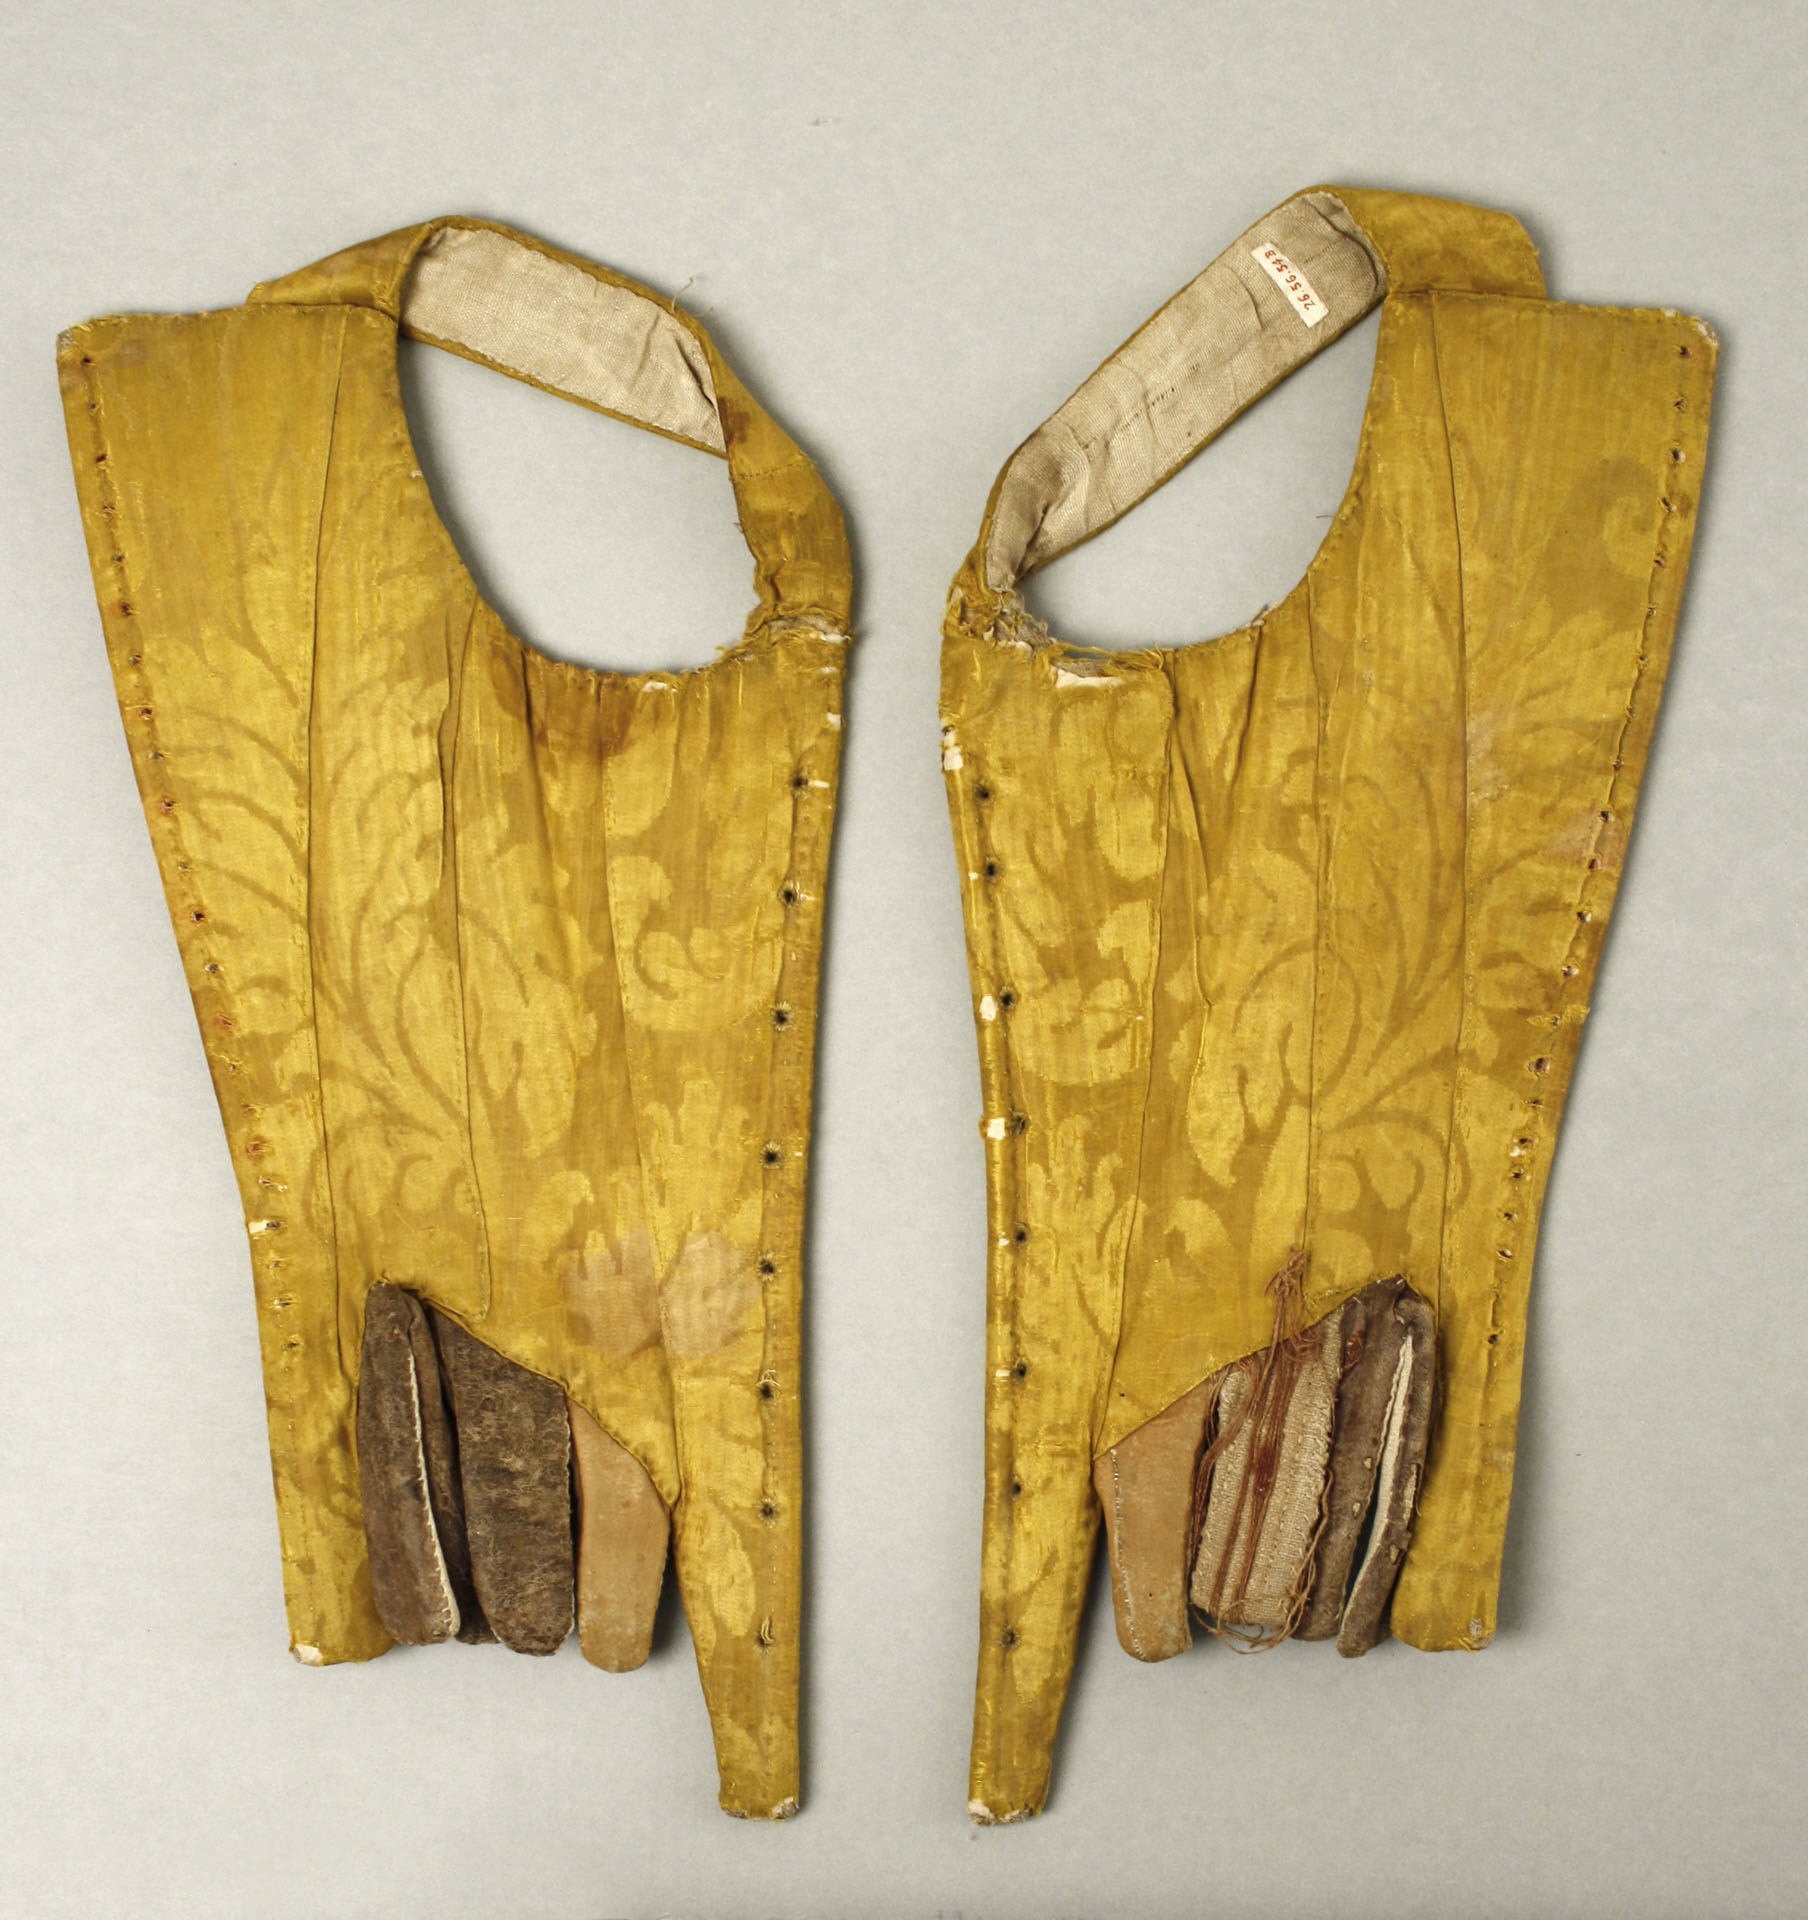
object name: stay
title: Stays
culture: italian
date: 1734-1766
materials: silk